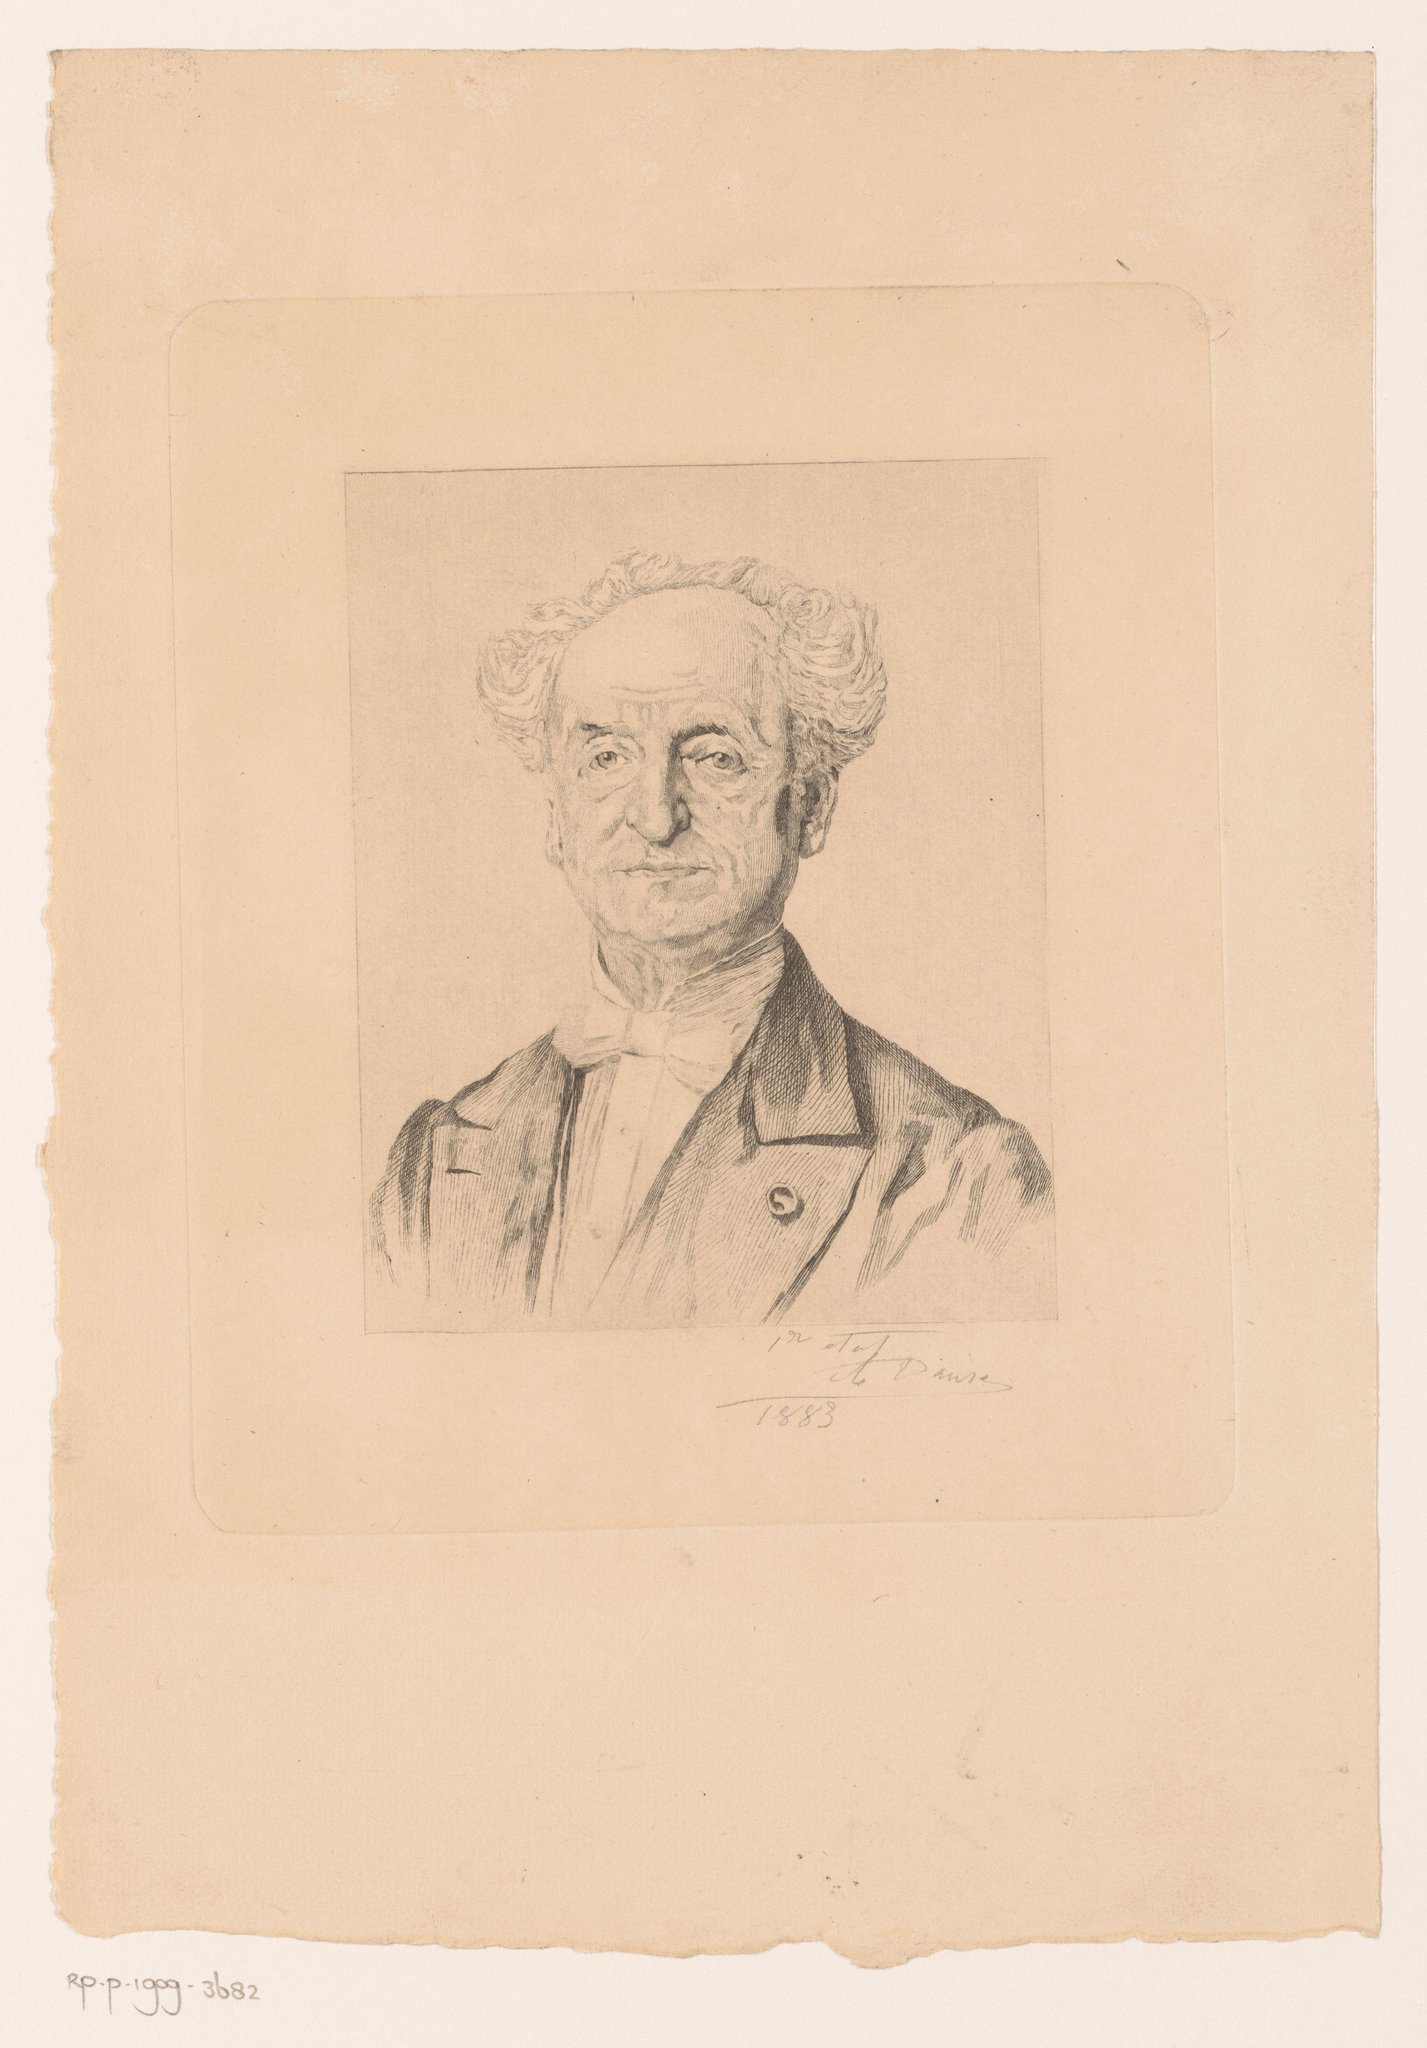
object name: print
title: Portret van een onbekende man met witte vlinderstrik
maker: auguste danse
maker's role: print maker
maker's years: 1829-1929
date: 1883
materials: paper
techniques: etching, intaglio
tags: adult man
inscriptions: collector's mark: Lugt 2228, annotation: ‘1er etat’